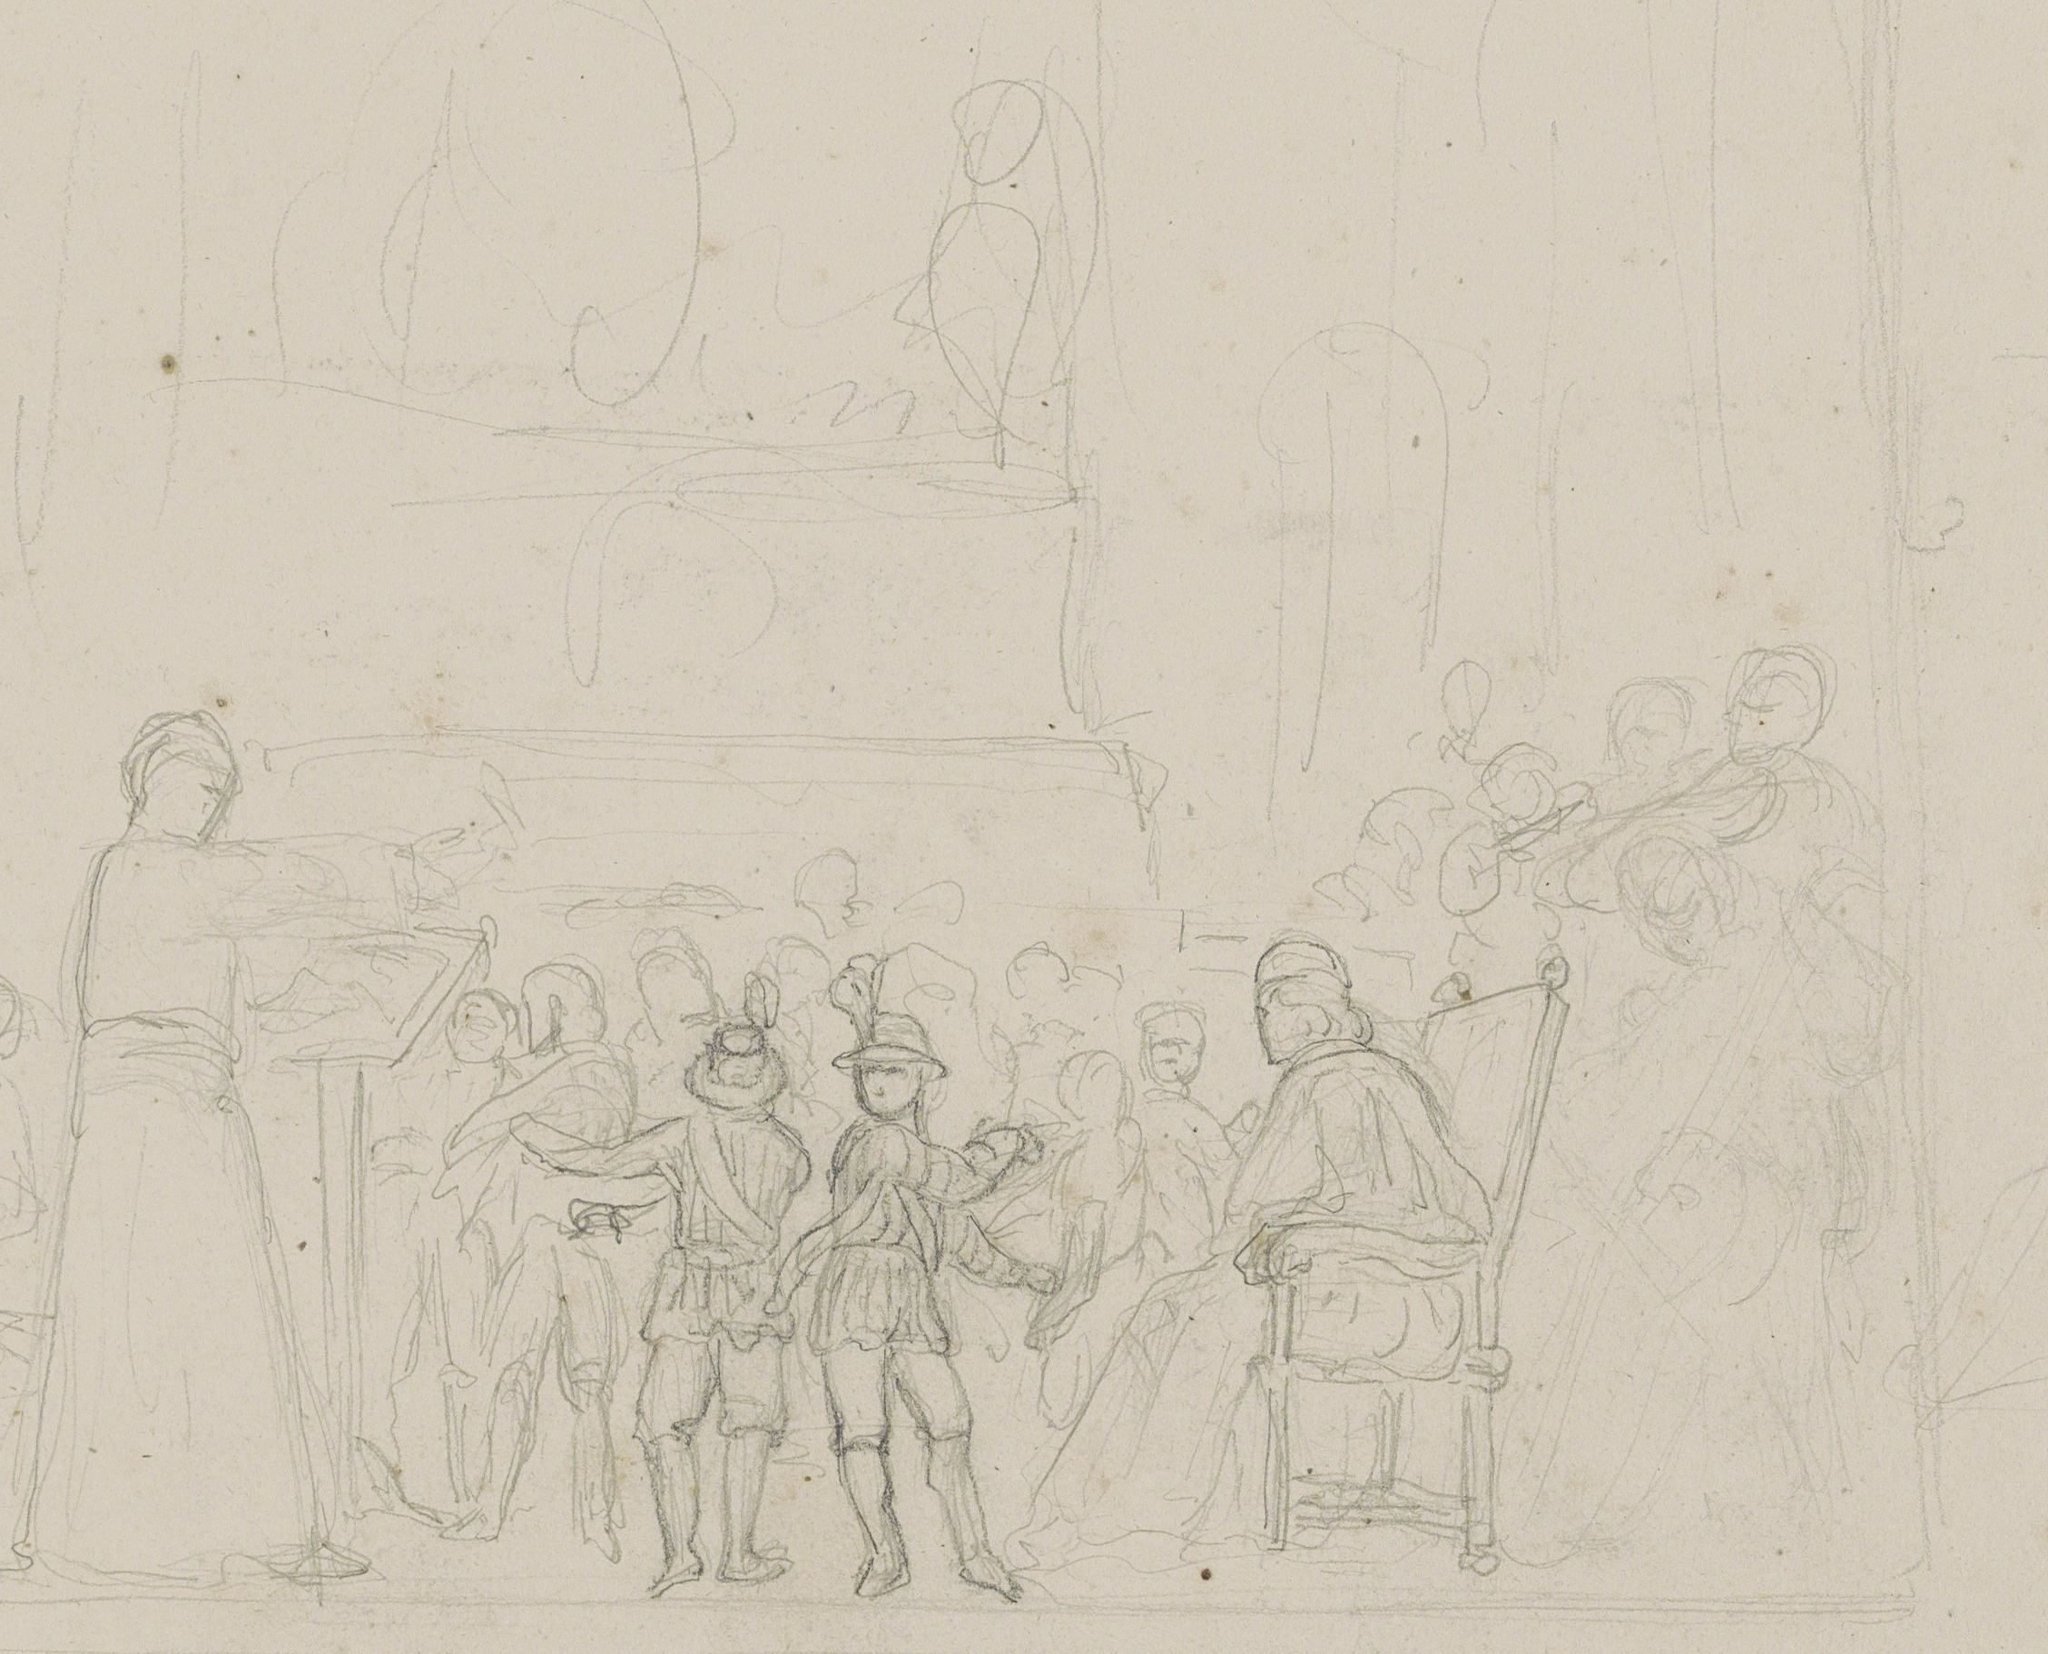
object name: sketchbook leaf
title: Interieur met figuren die naar een lezing luisteren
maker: gerrit postma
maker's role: draughtsman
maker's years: 1819-1894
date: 1829-1894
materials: paper, pencil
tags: address, talk, lecture (~ meeting)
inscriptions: annotation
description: Op de voorgrond staat een man achter een katheder. Hij spreekt een groep mensen toe. Twee soldaten staan voor deze groep. Tekening in een kader. Blad 21 recto uit een schetsboek met 35 bladen.